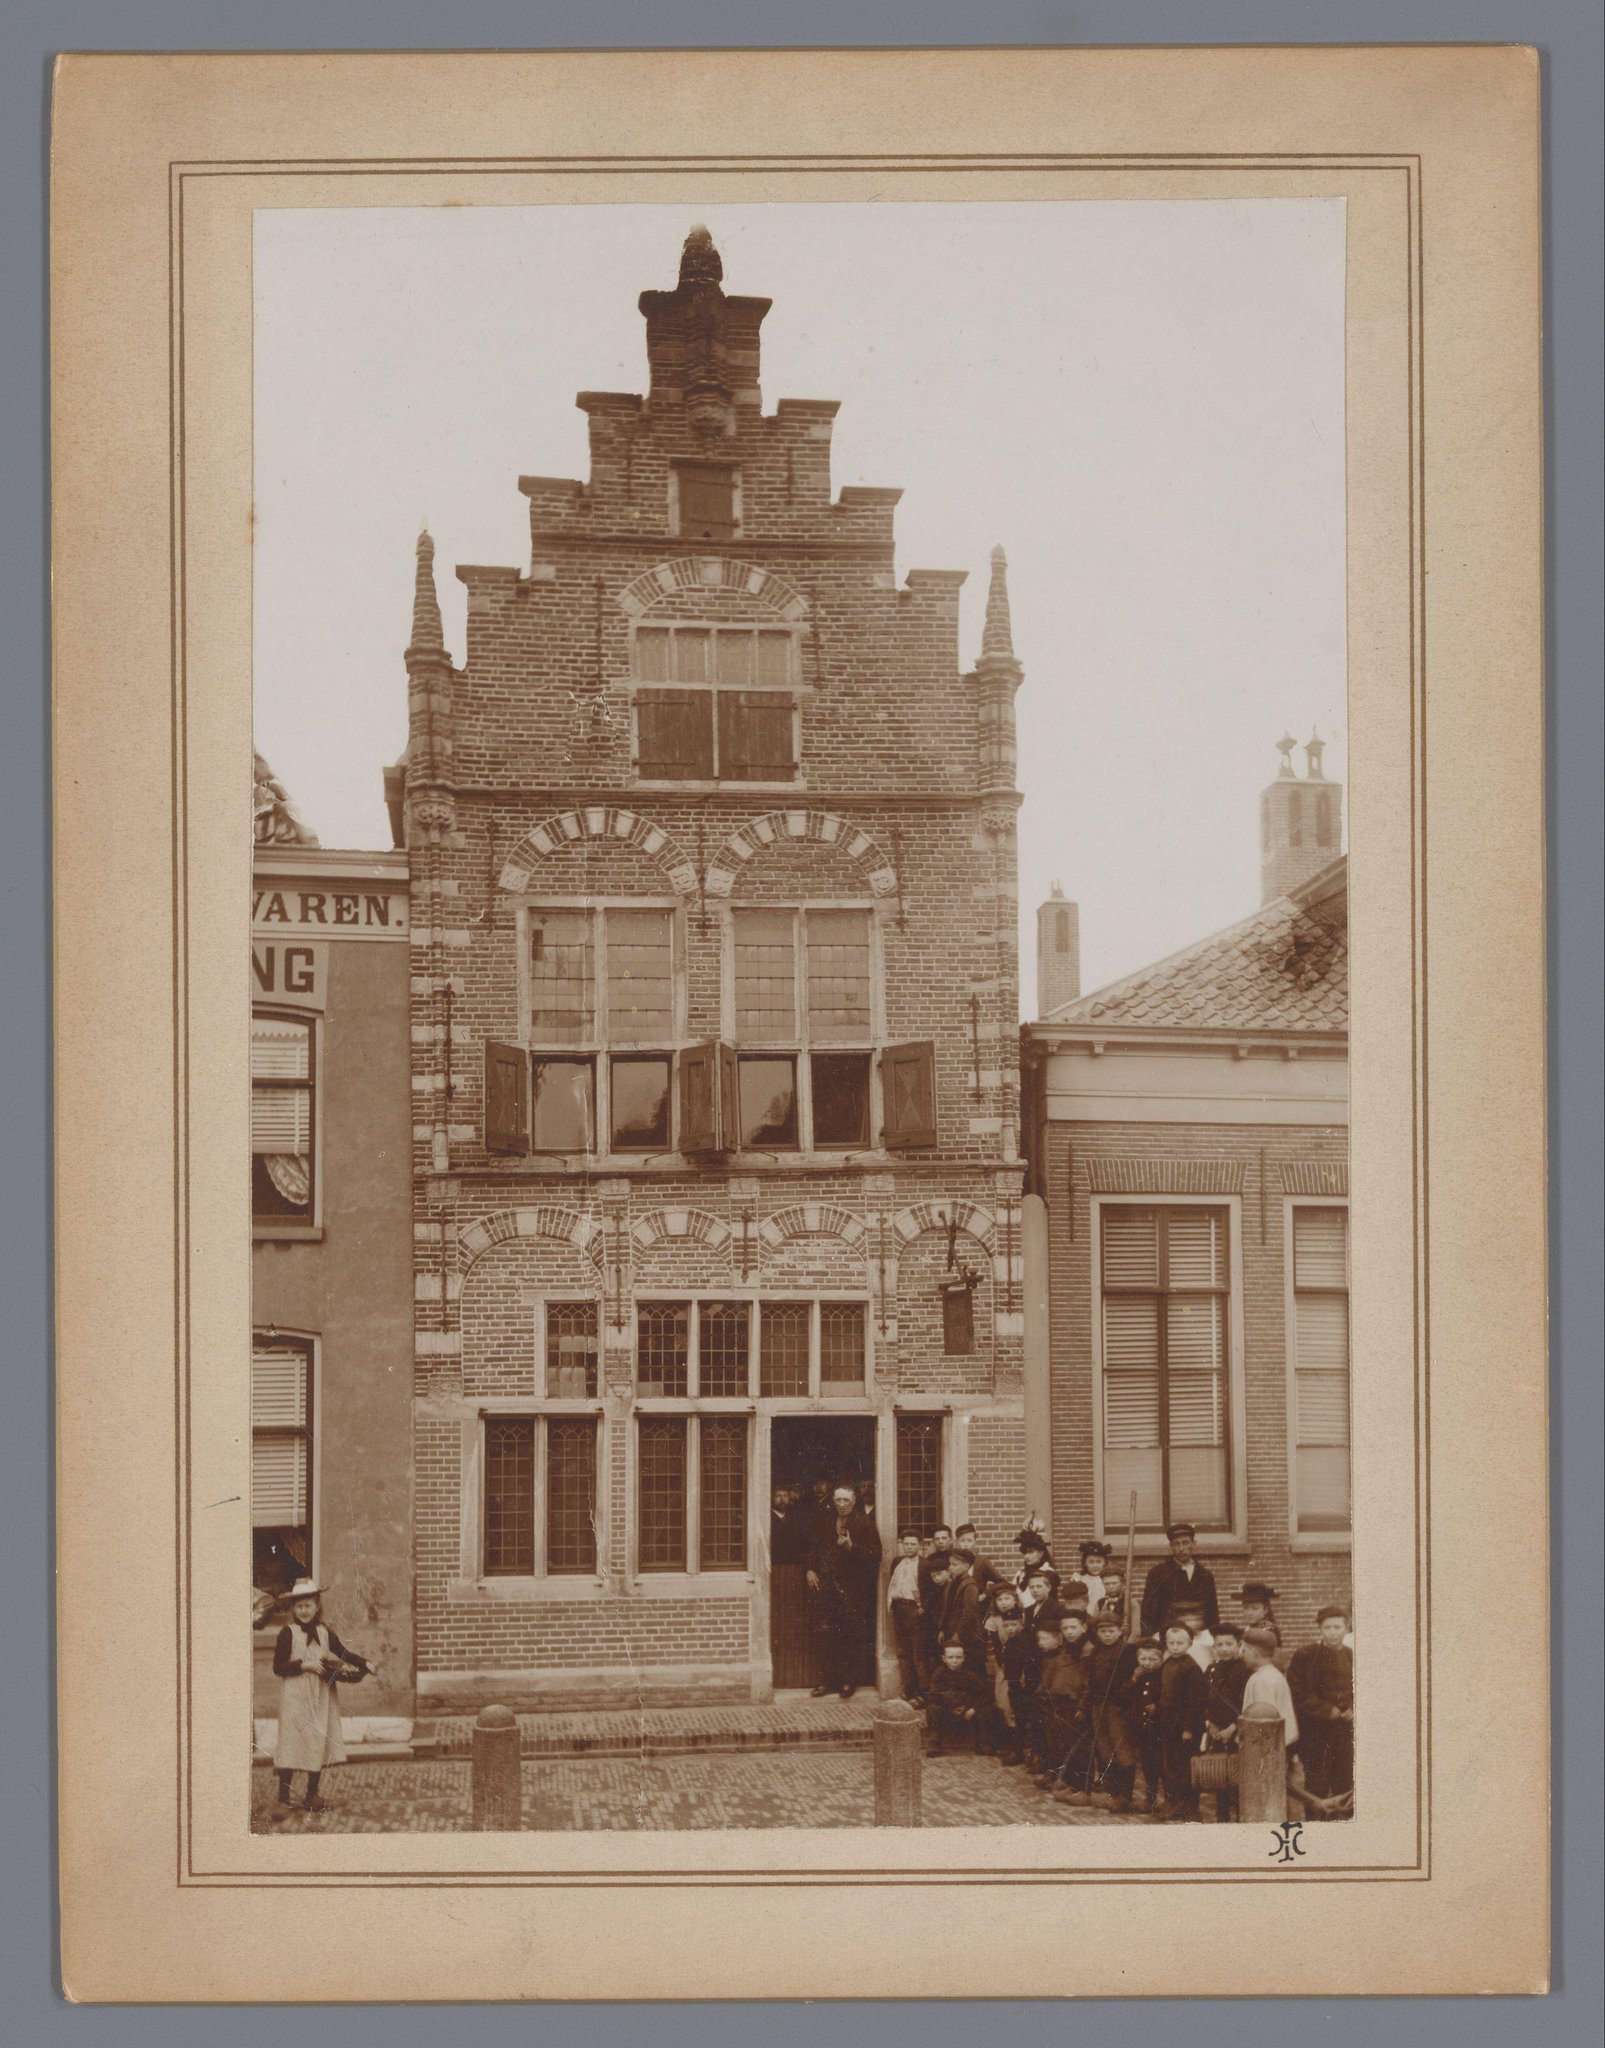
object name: photograph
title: Gezicht op het Edams Museum te Edam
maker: Anonymous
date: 1895-1910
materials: cardboard, photographic support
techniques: collodion silver print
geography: edam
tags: permanent exhibition, museum, façade (of house or building)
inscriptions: monogram: ‘[HI]’, annotation: ‘Museum te Edam’